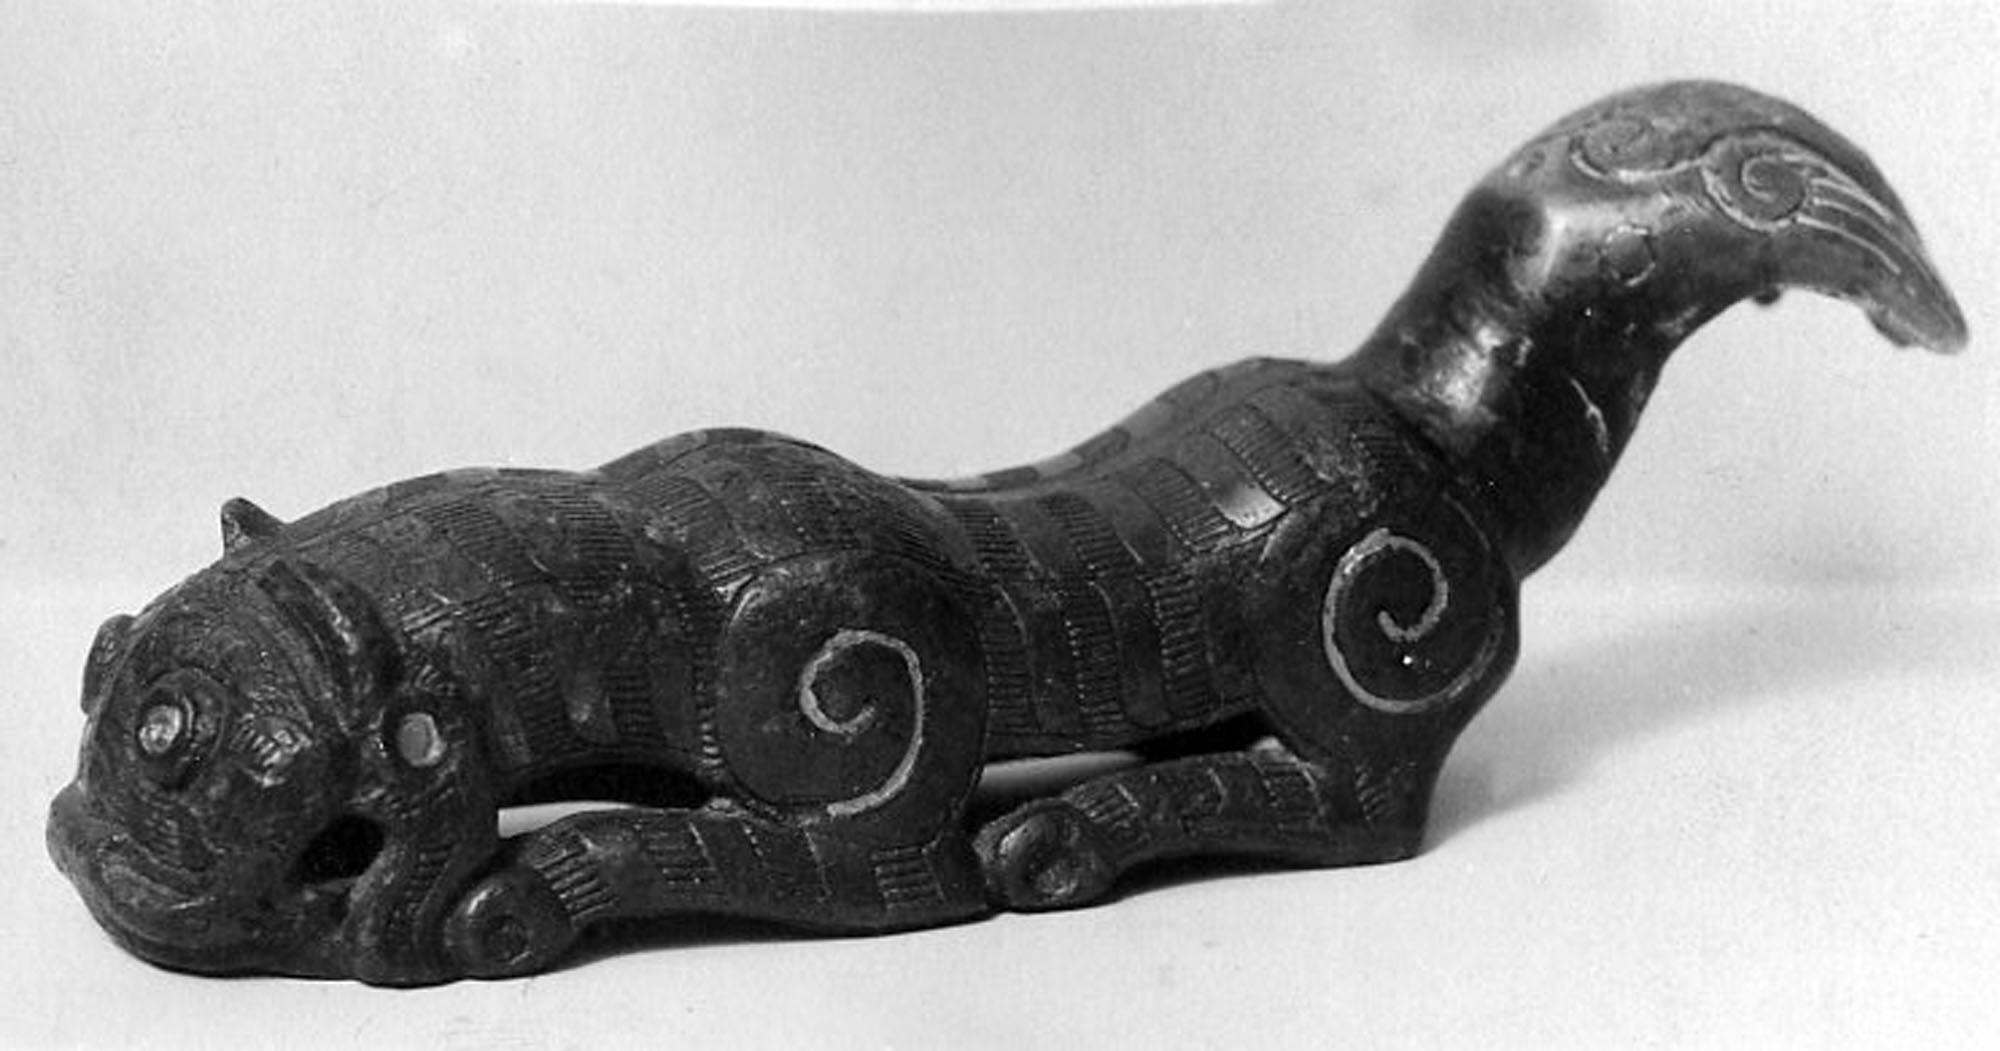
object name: figurine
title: Crouching Tiger Figure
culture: chinese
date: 206 BCE-250 CE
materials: bronze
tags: tigers